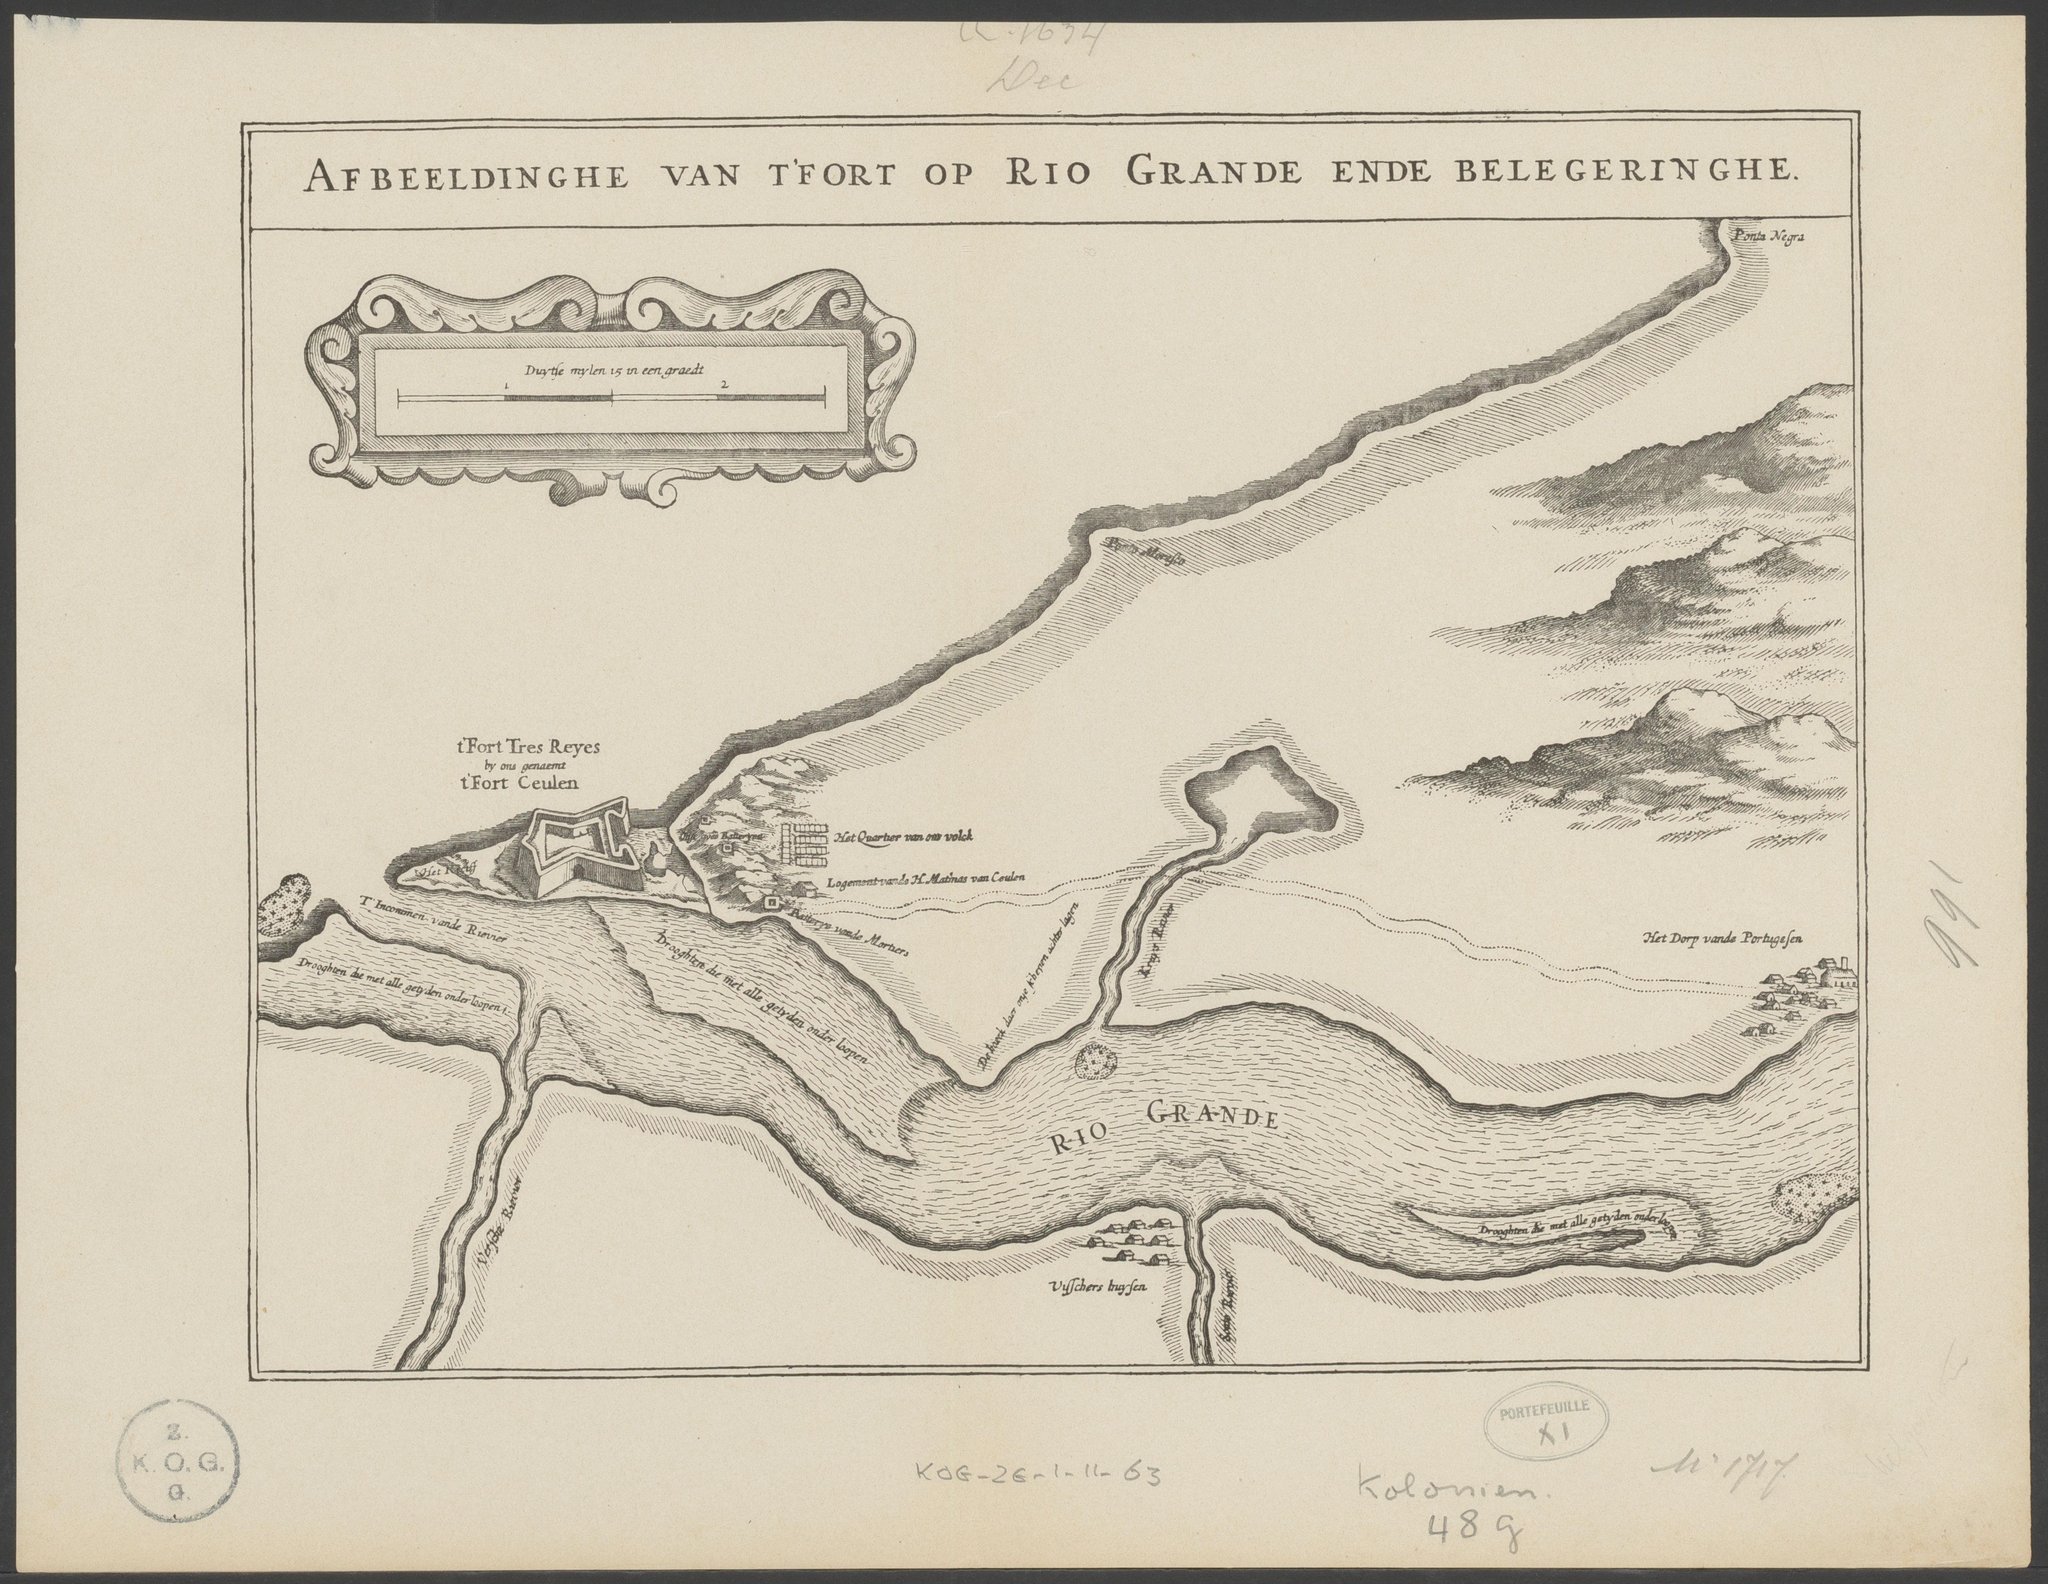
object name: print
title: Fort op Rio Grande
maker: Anonymous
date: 1800-1899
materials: paper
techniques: lithograph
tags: fortress, spring, source of river or stream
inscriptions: collector's mark: Lugt 1641, stamp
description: Onderwerpsrubrieken binnen de Atlas Zeden en Gewoonten: Handel, nijverheid en verkeer, Koophandel, Handel op de Koloniën.